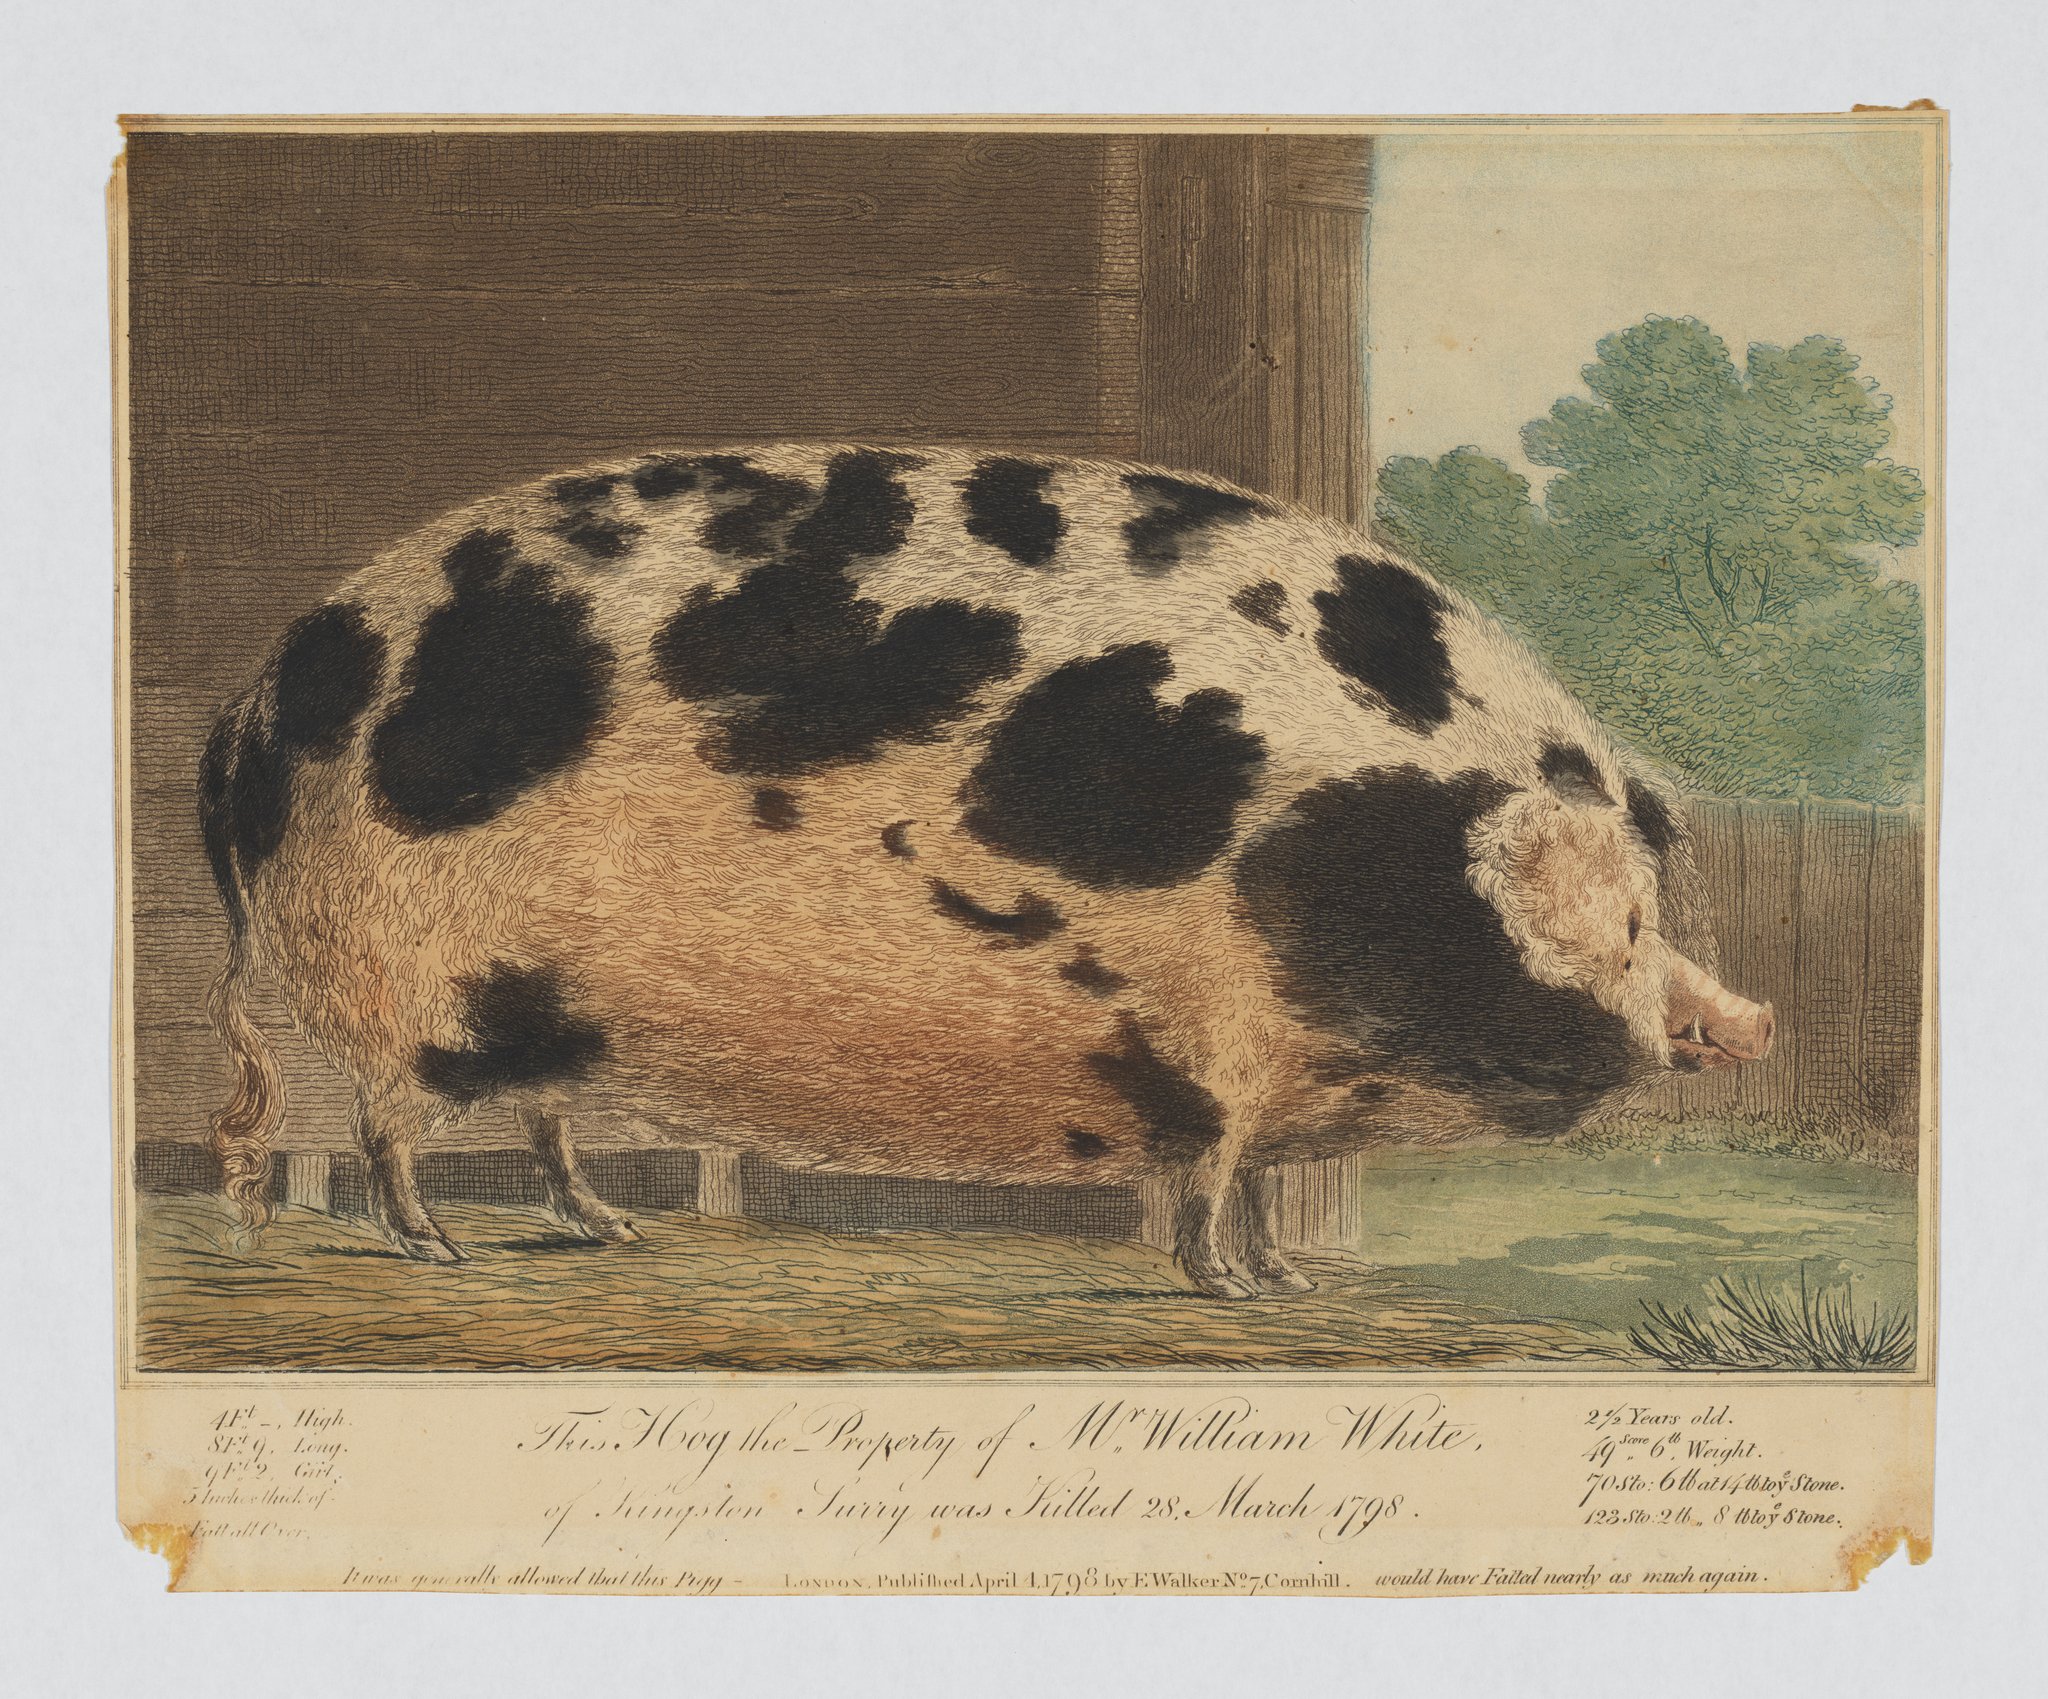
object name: print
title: This Hog the Property of Mr. William White of Kingston, Surrey...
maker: anonymous, british, 18th century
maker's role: artist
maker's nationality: british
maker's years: 1700-1800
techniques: aquatint, etching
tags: pigs